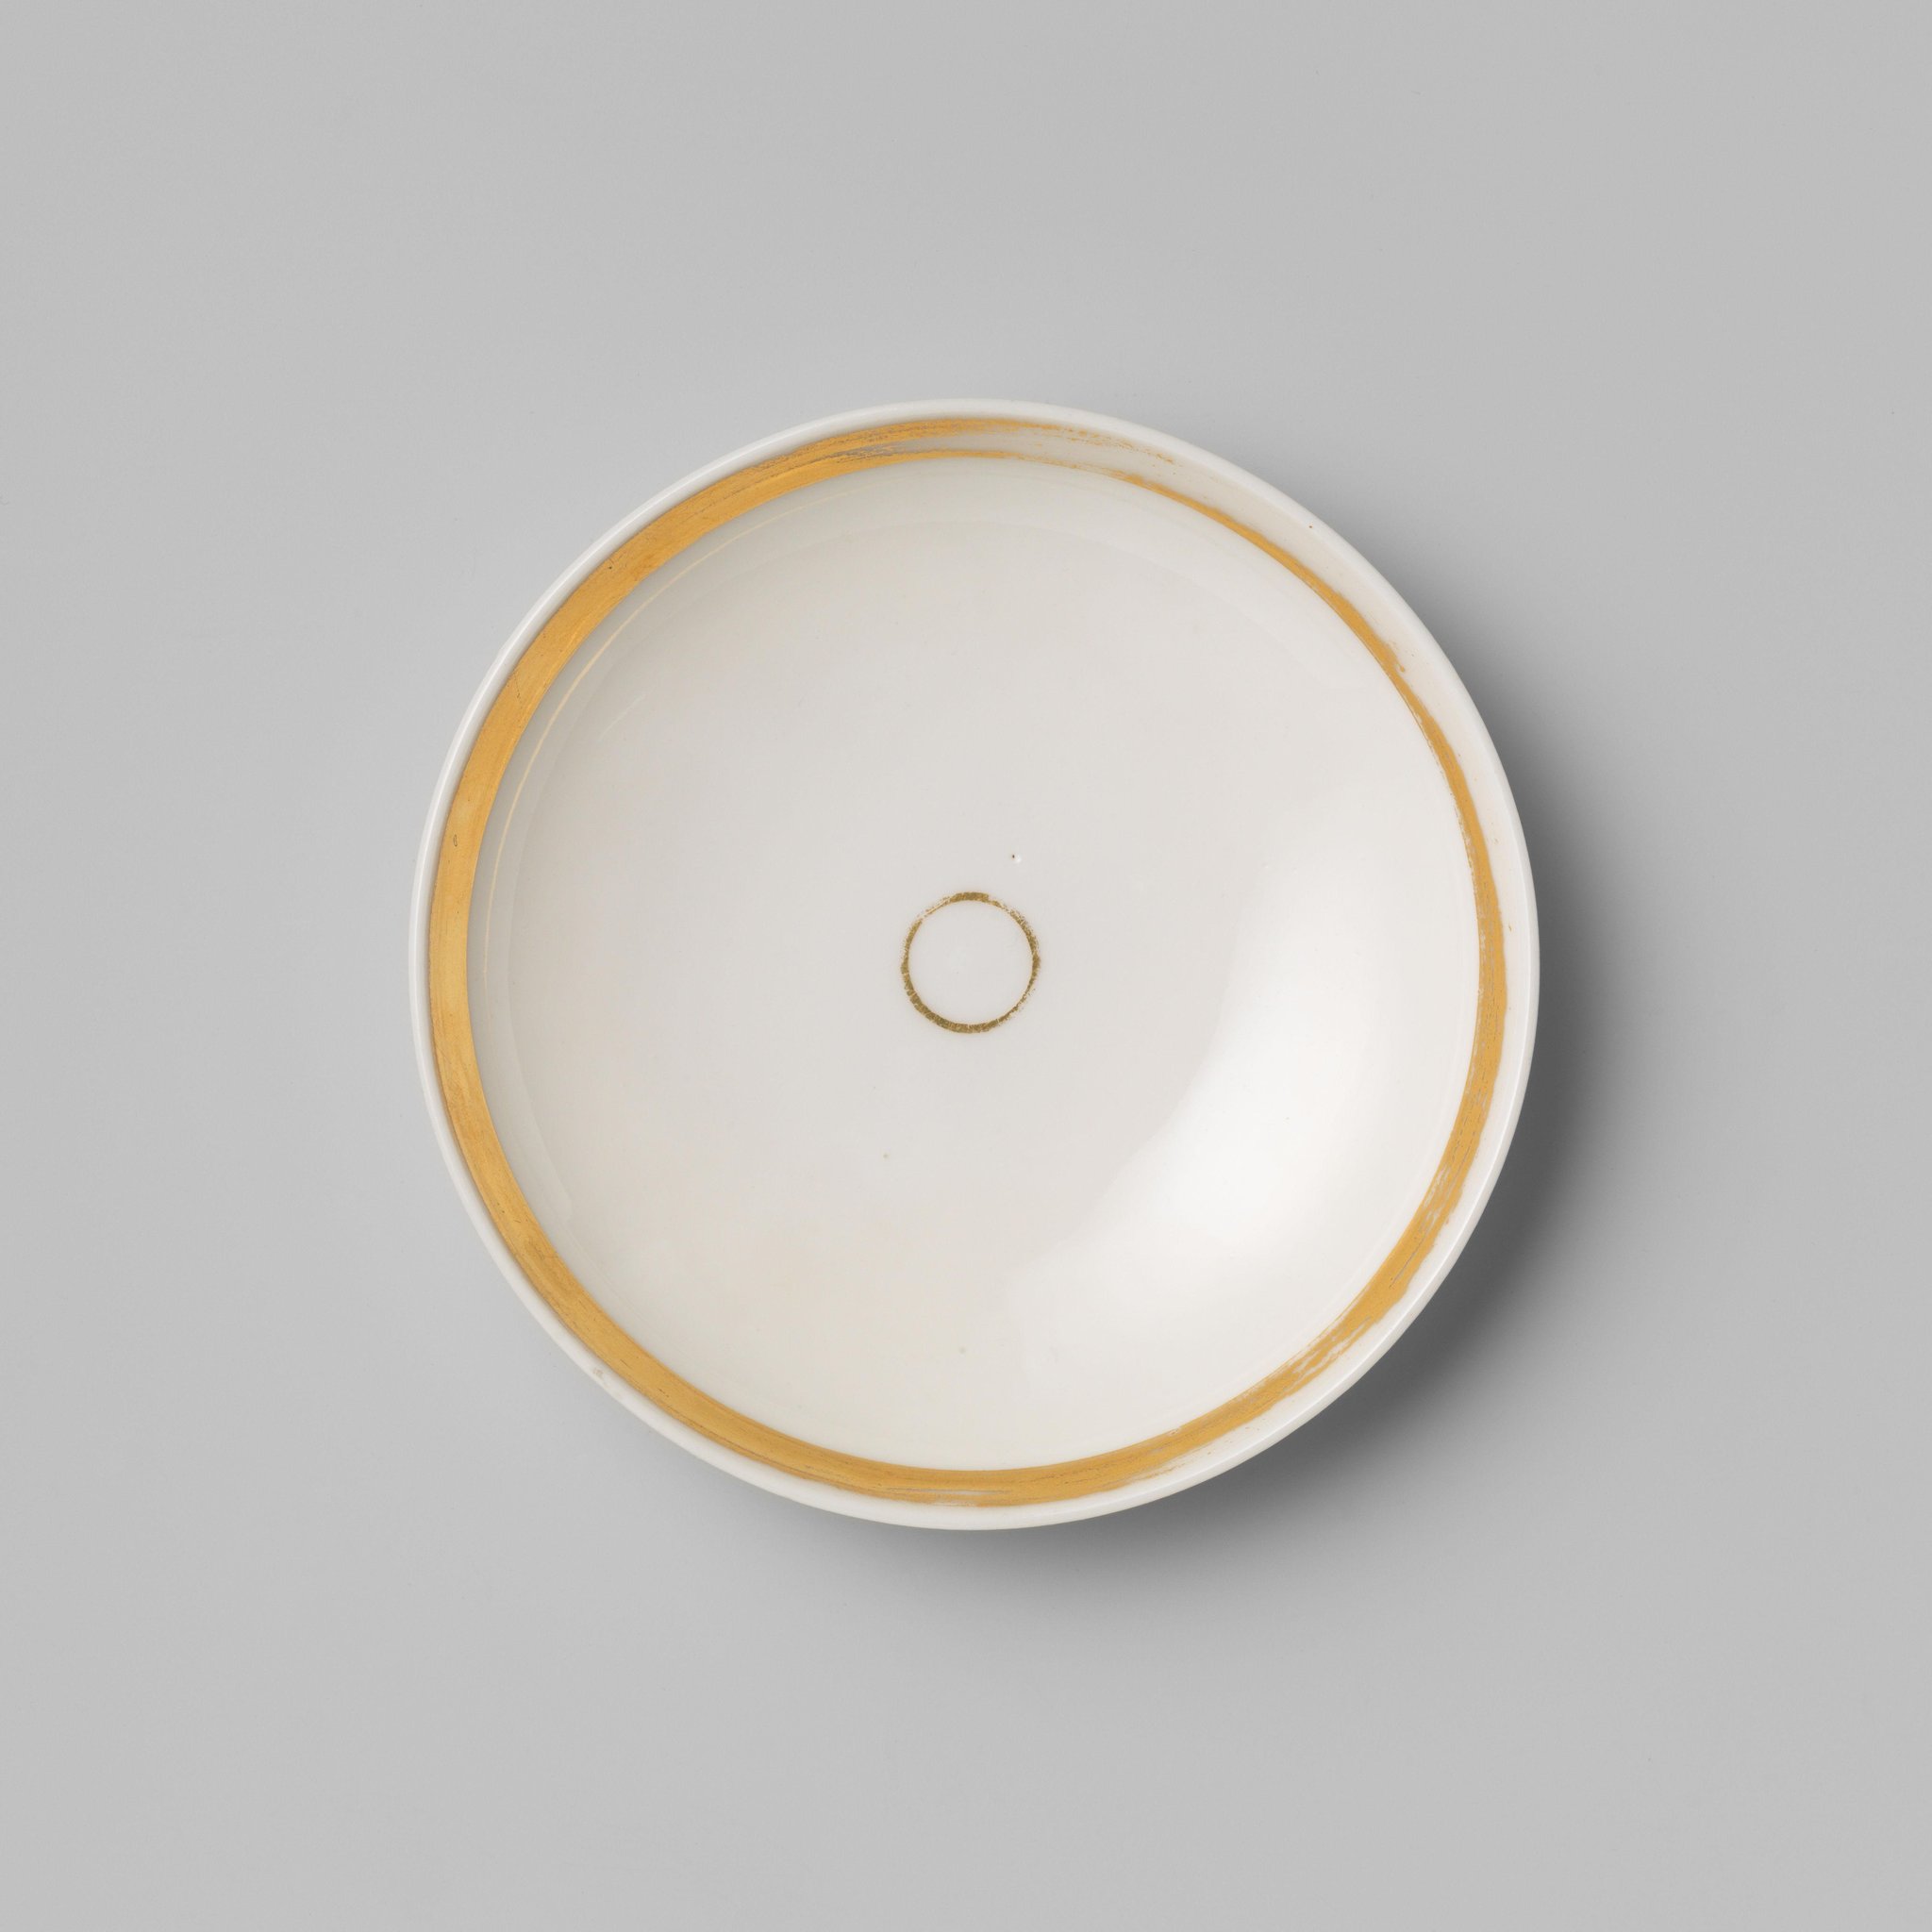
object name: platter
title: Saucer with a medallion and gold border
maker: Anonymous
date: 1850-1899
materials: glaze, gold, paint, porcelain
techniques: firing, forming, gilding, turning, vitrification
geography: europe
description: Schotel van porselein met langs de schotelrand een brede gouden bies en midden op het plat een gouden cirkel. Behoort bij een serie van twaalf kop en schotels waarvan de koppen zijn versierd met een drukdecor in zwart, voorstellende spelende kinderen of volwassenen in een landschap.